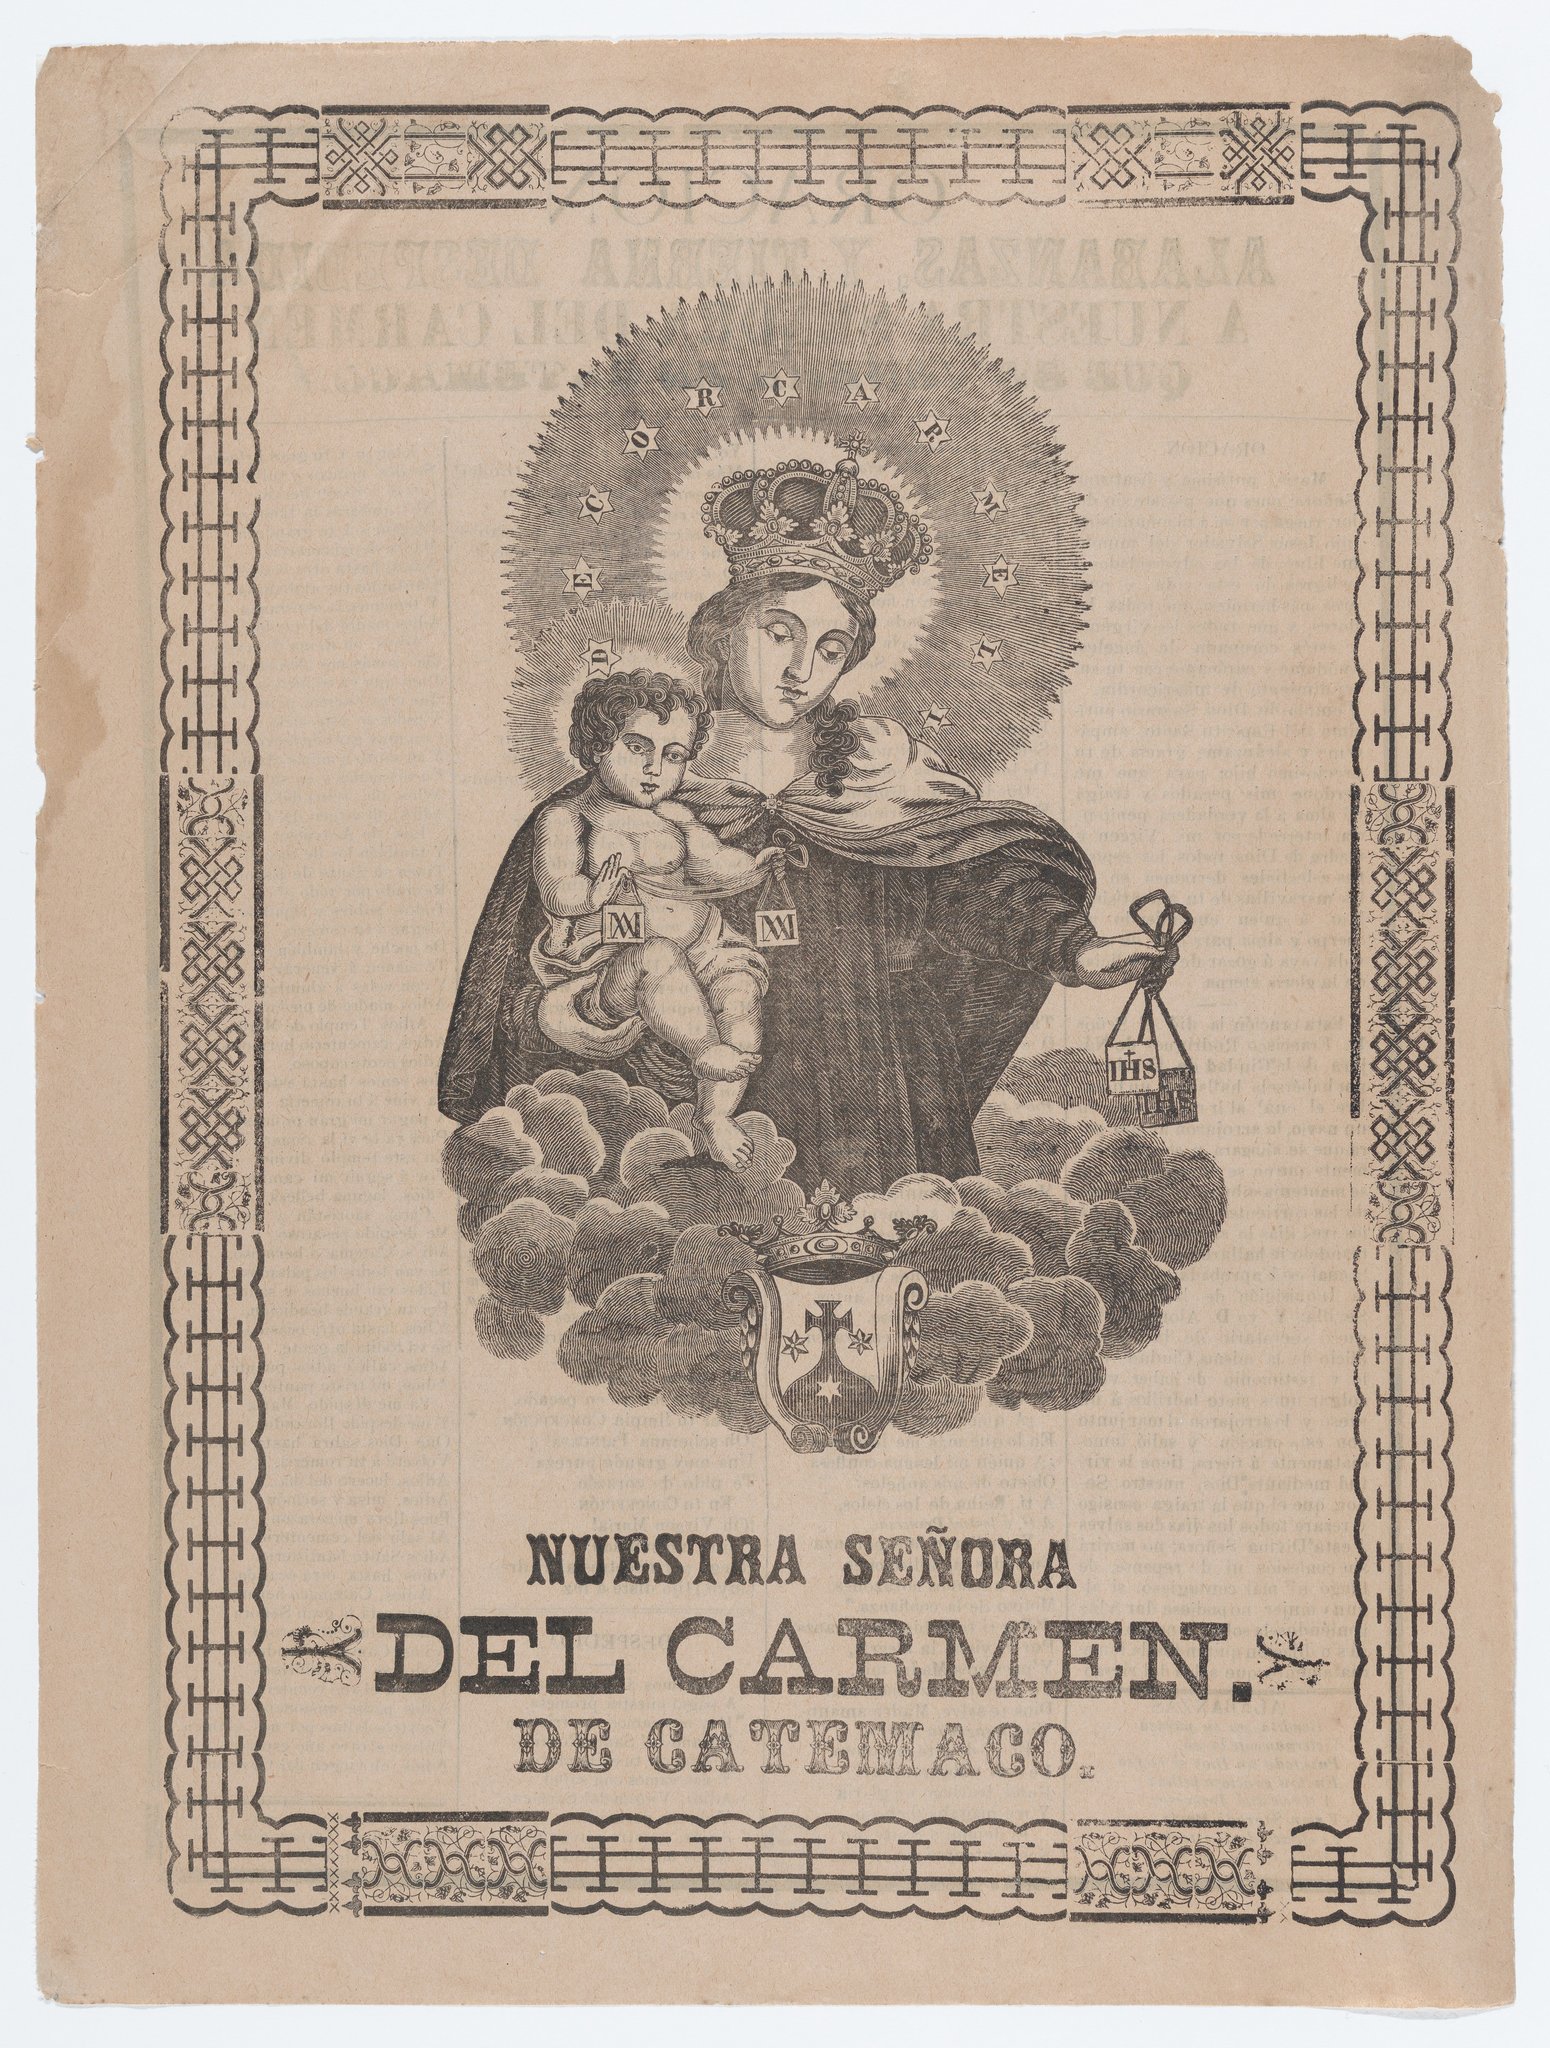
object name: print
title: Our Lady of Catemaco holding the Christ Child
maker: josé guadalupe posada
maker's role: artist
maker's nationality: mexican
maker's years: 1852-1913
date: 1911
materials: paper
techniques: letterpress, lithograph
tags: madonna and child,coat of arms